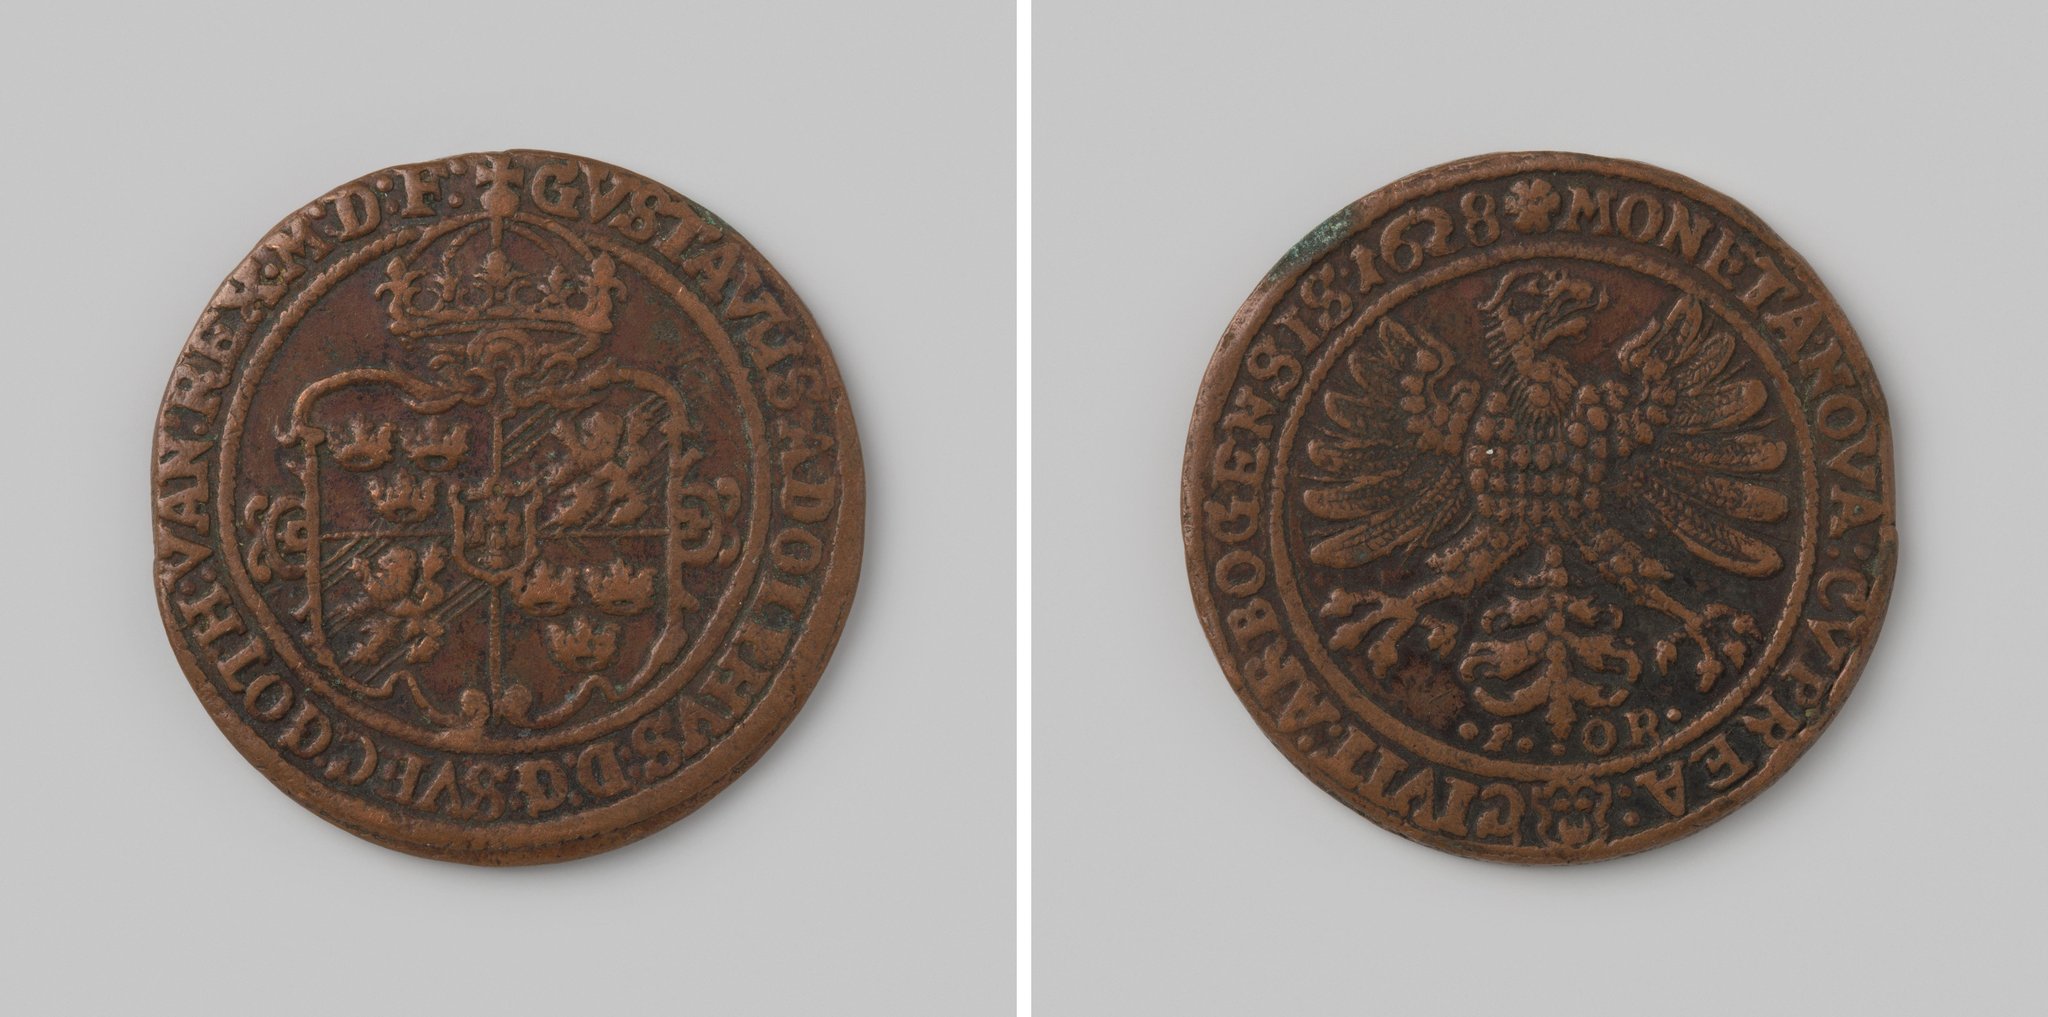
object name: coin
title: öre uit Arboga in Zweden van Gustaf II Adolf, 1628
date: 1628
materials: copper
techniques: striking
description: Koperen munt. Voorzijde: gekroond samengesteld wapenschild. Keerzijde: eenkoppige adelaar naar rechts. Waarde-aanduiding 1 ör in veld onder adelaar. Jaartal in omschrft. Gladde rand.